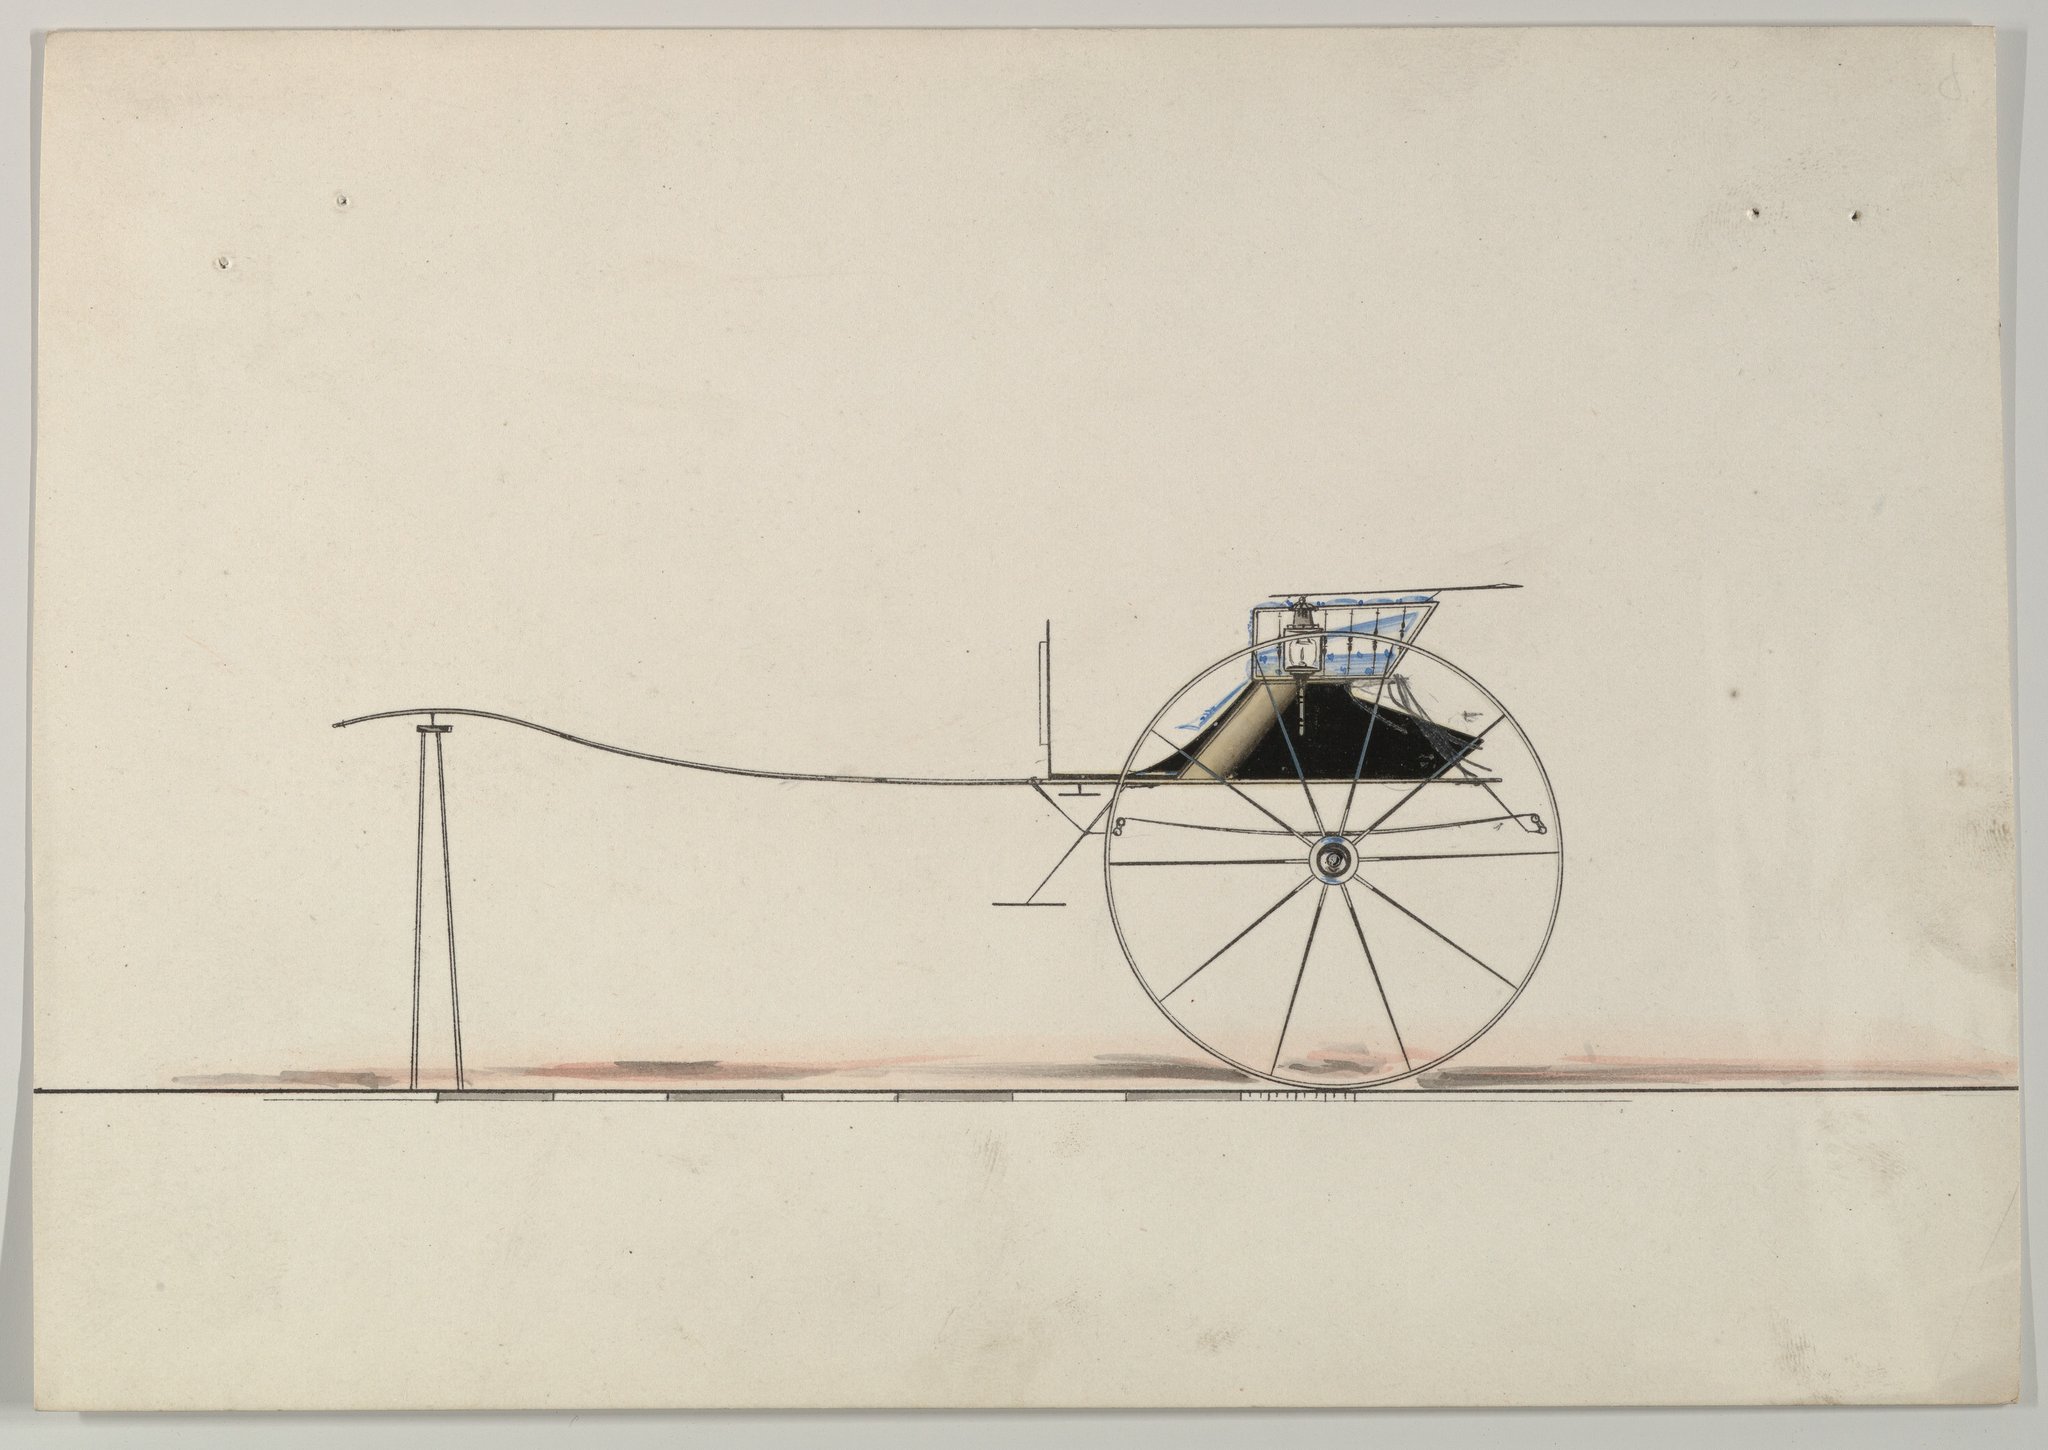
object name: drawing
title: Gig (unnumbered)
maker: brewster & co.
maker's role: manufacturer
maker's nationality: american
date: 1850-1874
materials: gouache, graphite, gum arabic, ink, watercolor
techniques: pen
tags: carriages